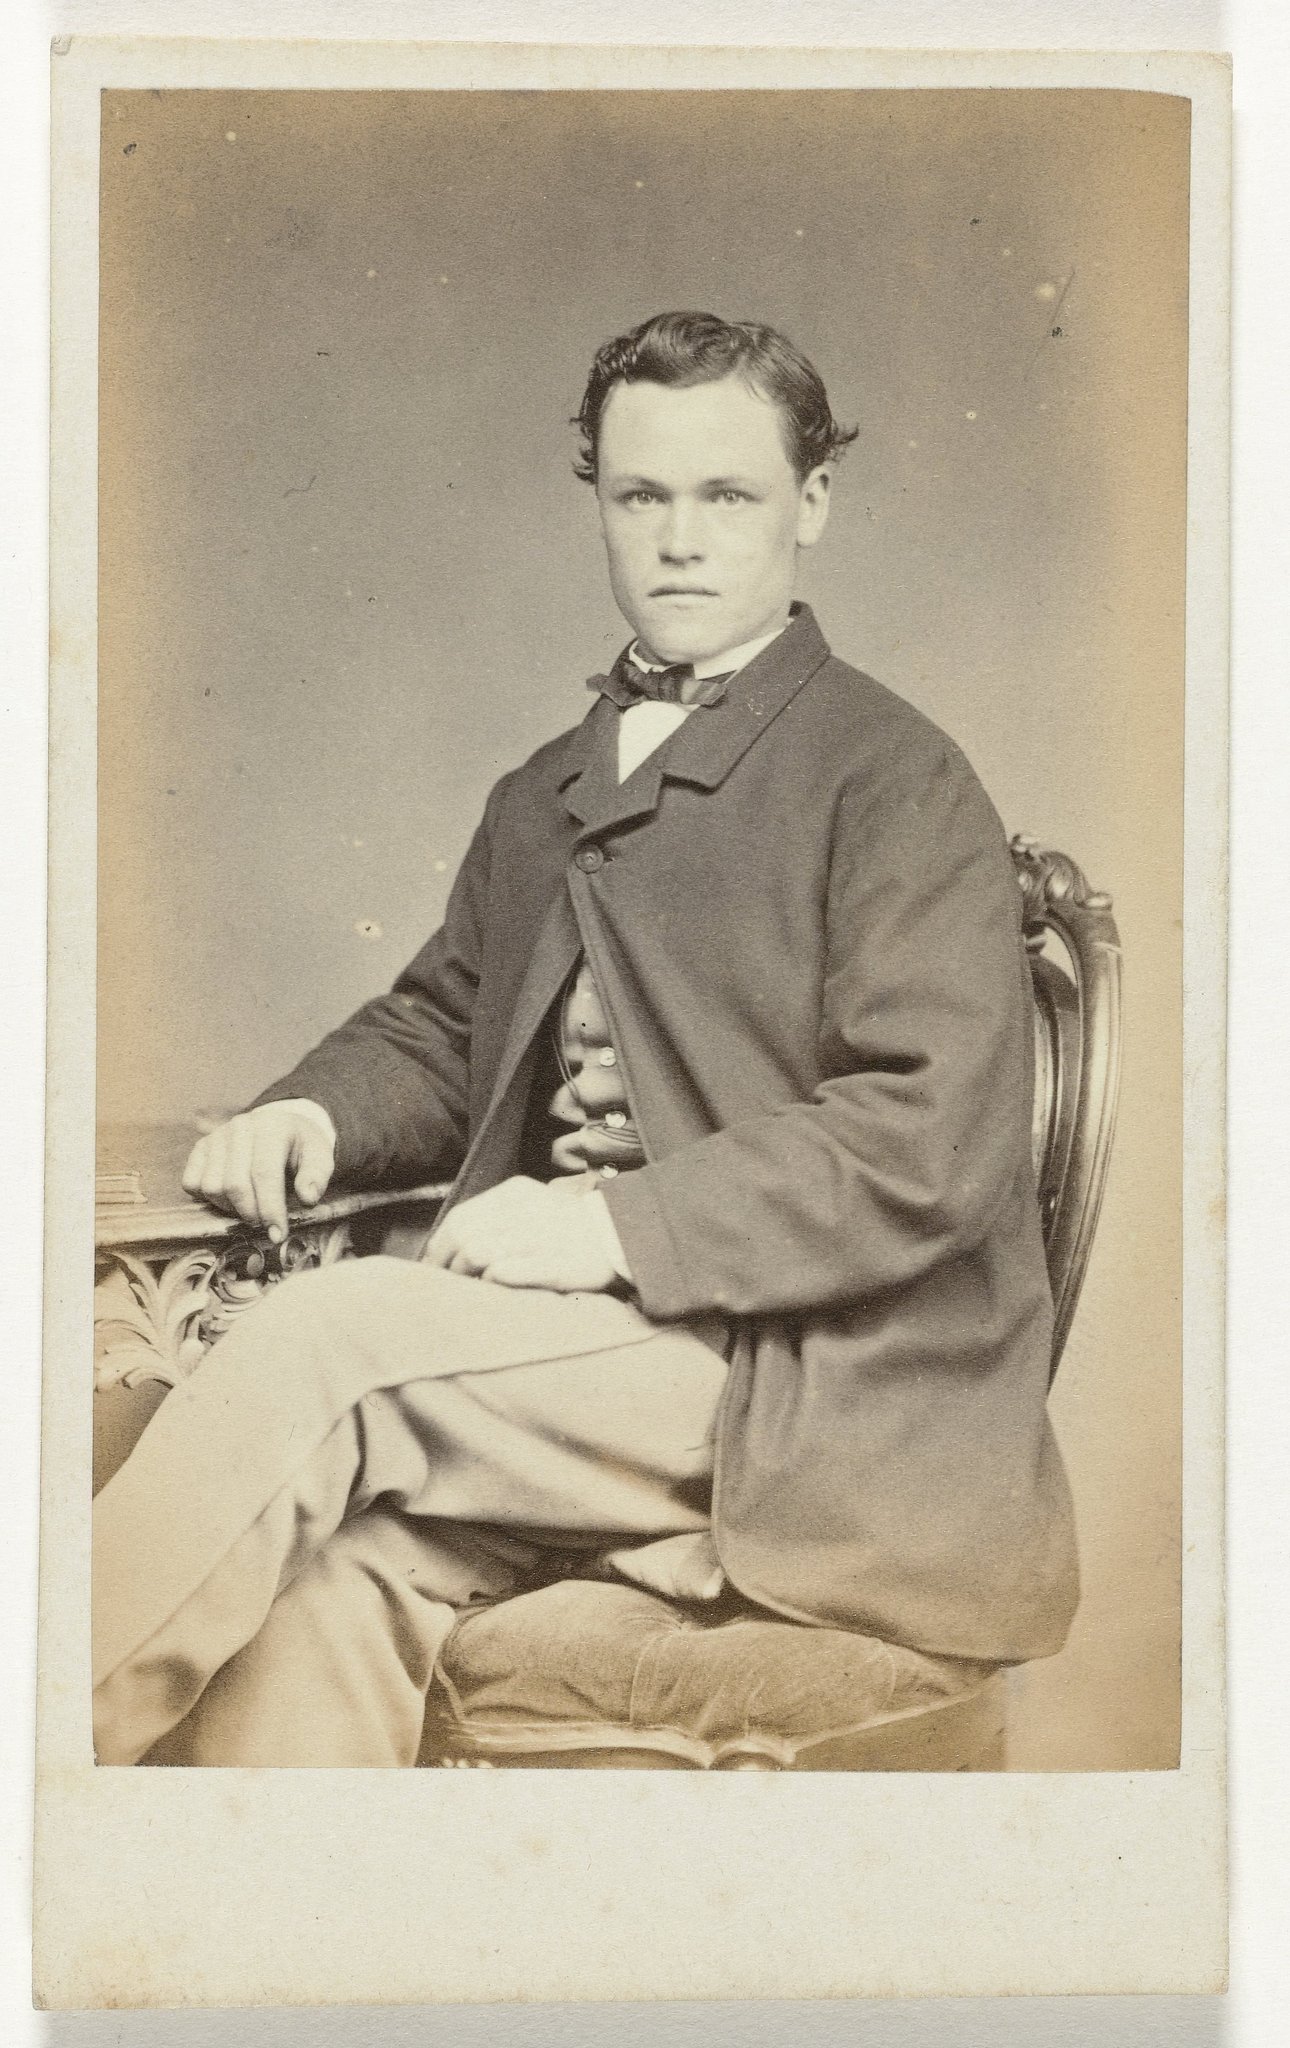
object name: photograph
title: Portret van een jonge man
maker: louis robert werner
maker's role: fotograaf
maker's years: 1834-1896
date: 1860-1880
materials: cardboard, paper, photographic support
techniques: albumen print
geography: amsterdam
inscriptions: address: ‘PHOTOGRAPHISCH ATELIER // VAN // L.R. WERNER // voorheen // P. CARSTENSEN // Nieuwendijk H 201 // AMSTERDAM’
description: Portret van een een jonge man, zittend naast een tafel.